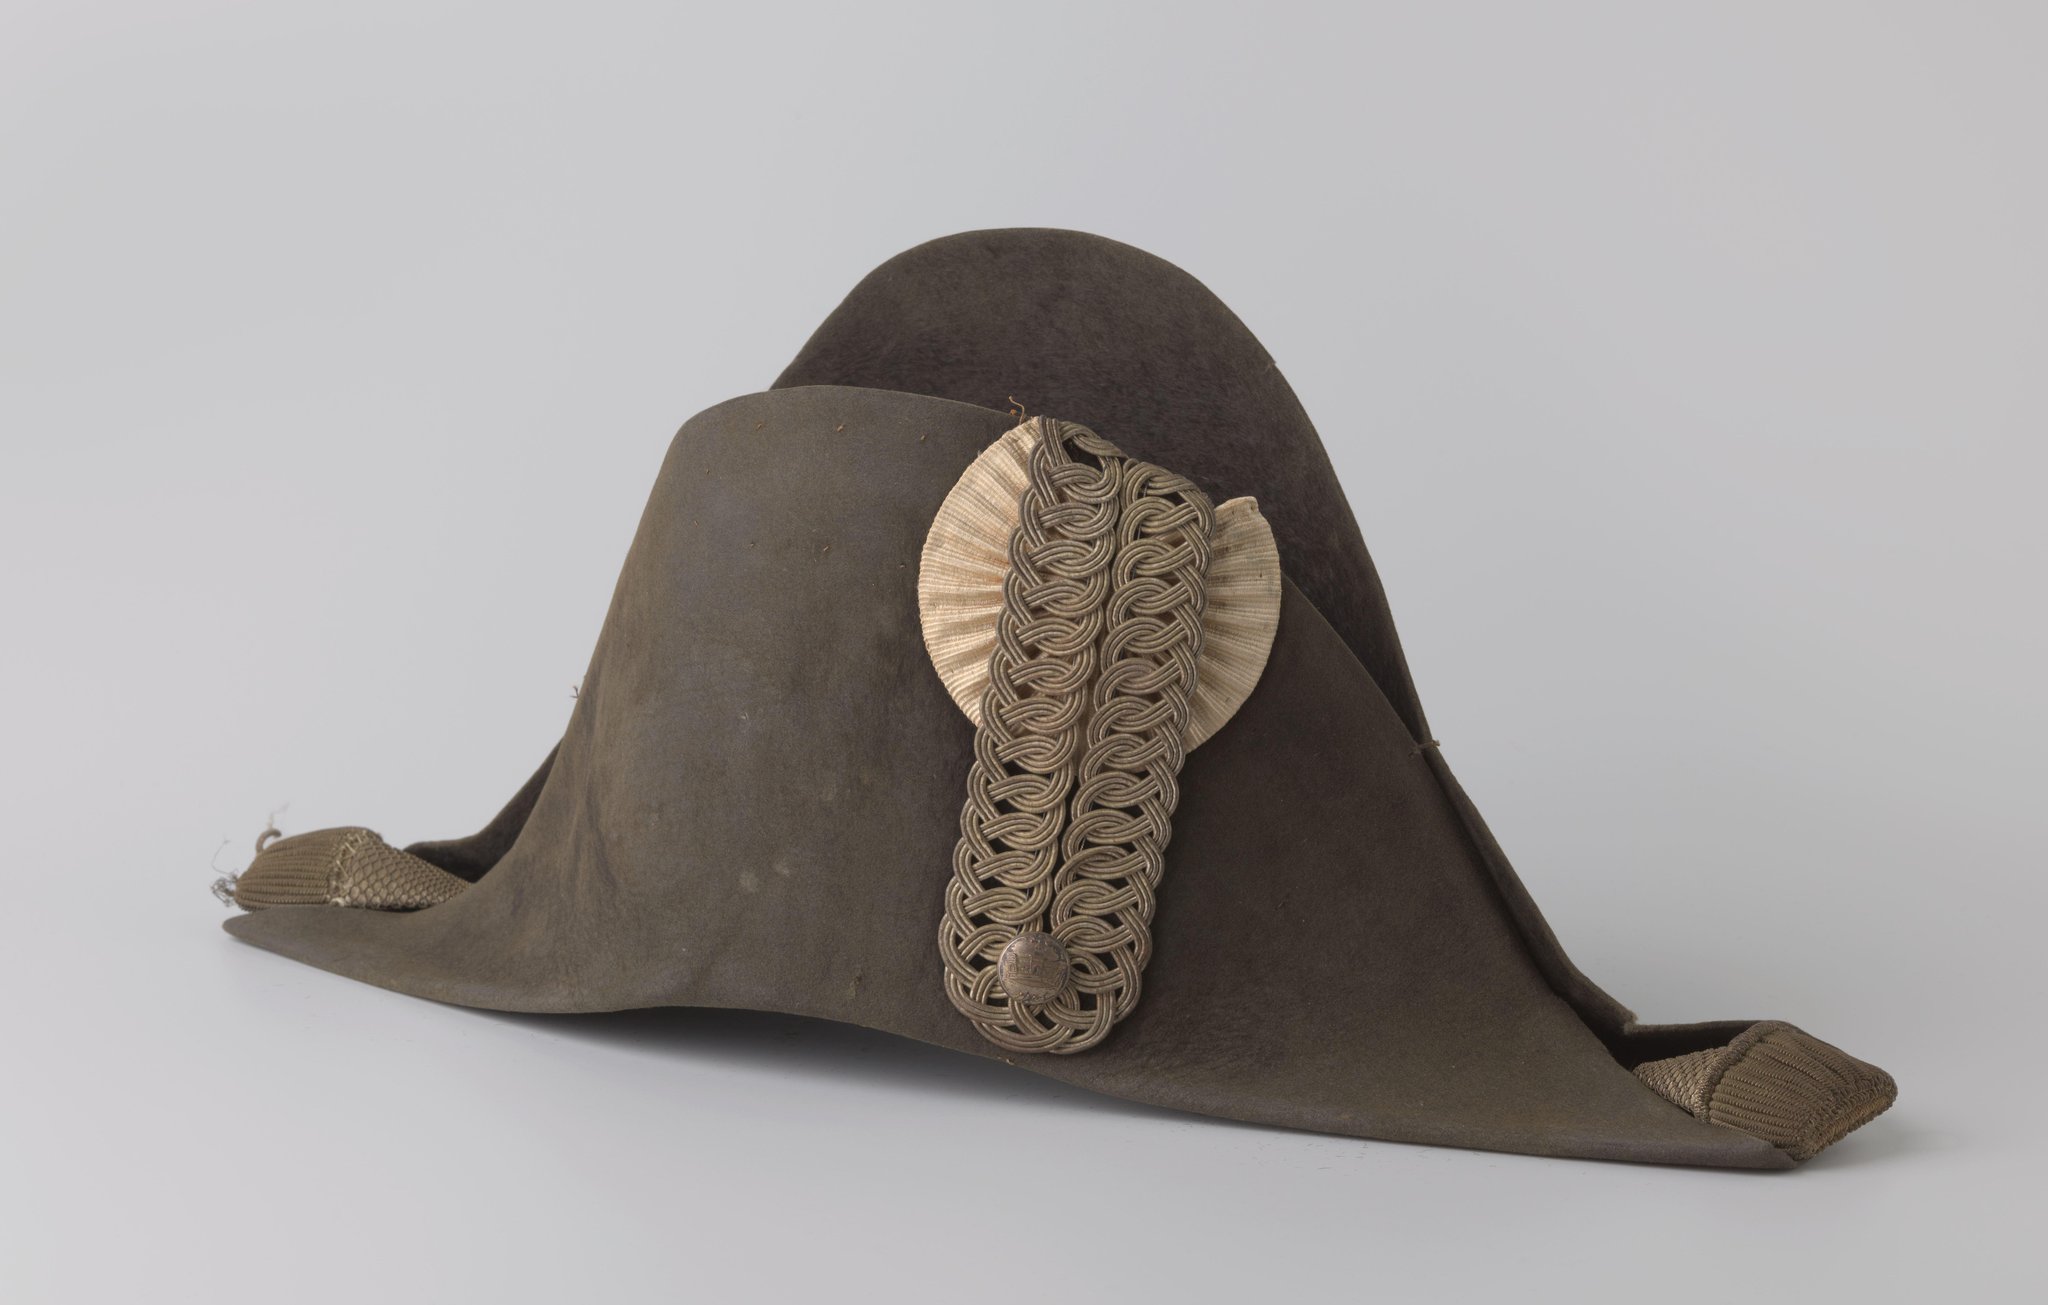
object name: corsaire, bicorne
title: Bicorne officier schutterij H. Pek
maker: Anonymous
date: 1830-1831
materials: alloy, felt, leather, paper, silk, silver, thread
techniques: braiding, forming, pressing, stitching, striking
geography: netherlands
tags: h. pek, netherlands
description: Hoofddeksel van zwart gesleten kastoor. Voor- en achterzijde elk een platte zilveren kwast middels een zilver koord aan elkaar verbonden. Aan een van de opgeslagen zijden lange zilveren lis met wit metalen knoop en kroon met stedenkroon. Hieronder grote oranje kokarde. Hieraan rood label met NM 10385-77b Roosdorp. Achter de lis een sleuf. Achterste kwast beschadigd. Voorste kwast los. Binnenwerk losse donkerbruin leren zweetband. Hieronder links een plakker: no 3 // 6 1/2 en rechts een stukje leer:: 7. Hoofddeksel was van H. Pek, officier van gezondheid 2e en 3e klasse schutterij 1830. Voering: zijde, in slechte staat.